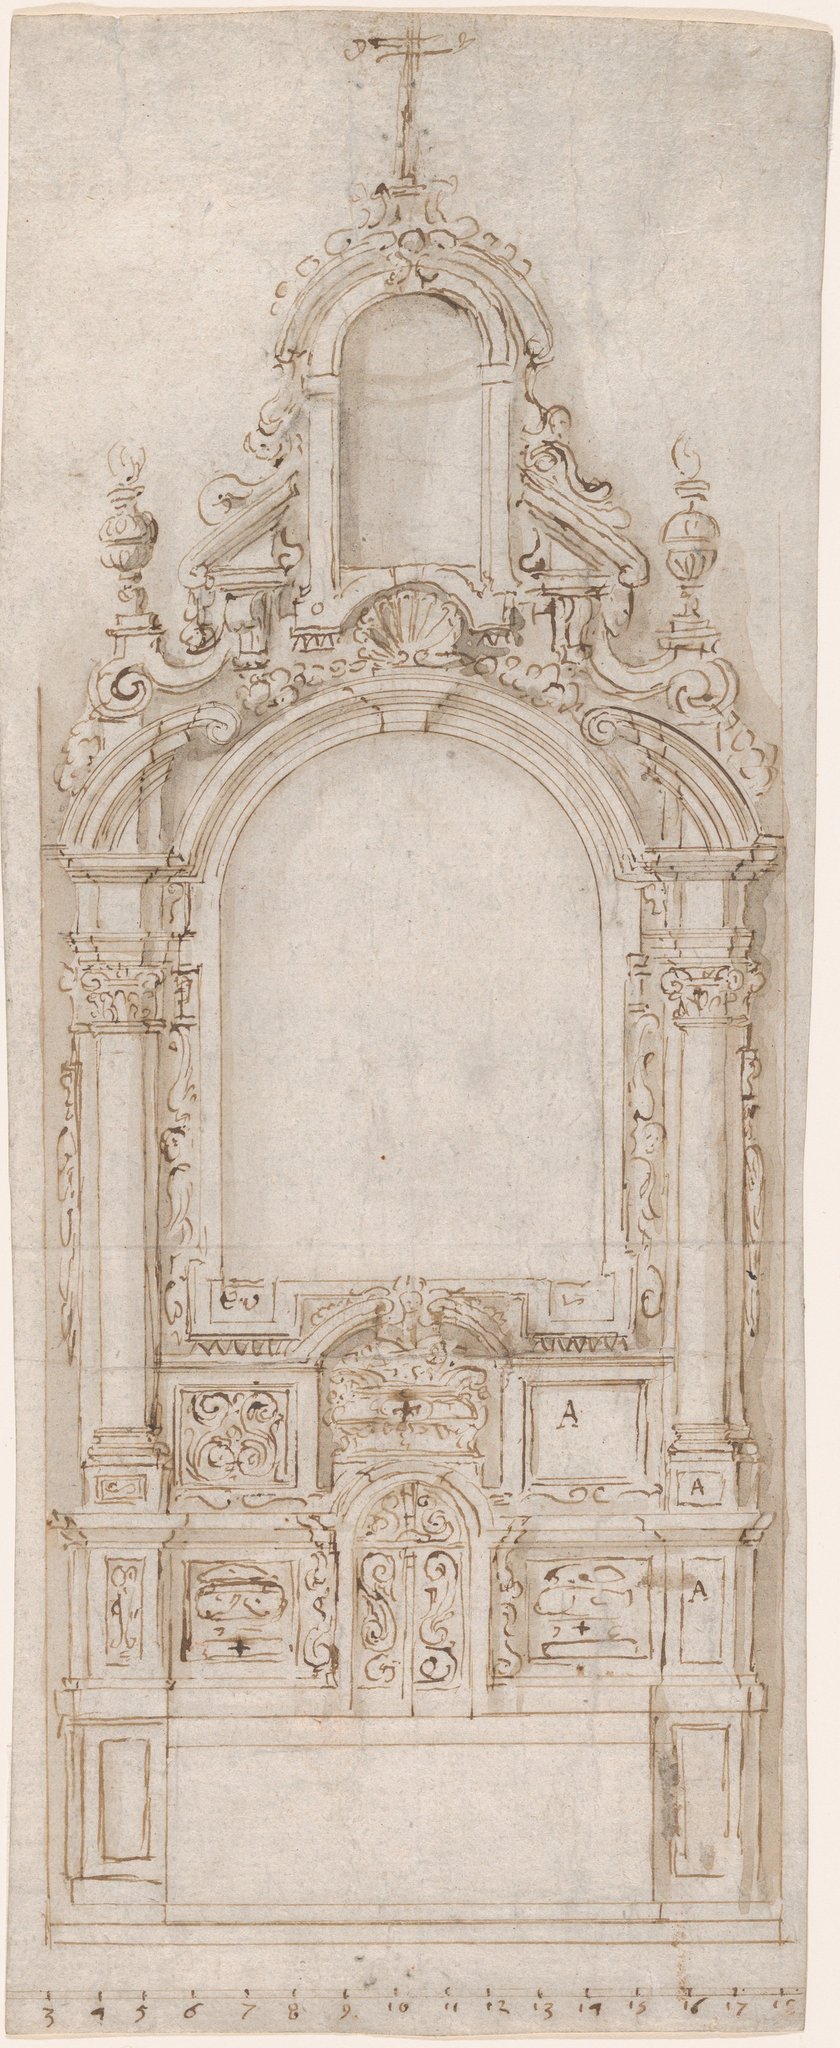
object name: drawing ornament architecture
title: Design for an Altar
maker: anonymous, flemish, 17th century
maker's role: artist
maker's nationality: flemish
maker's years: 1600-1700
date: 1601-1700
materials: ink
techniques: brush, pen, wash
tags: altars